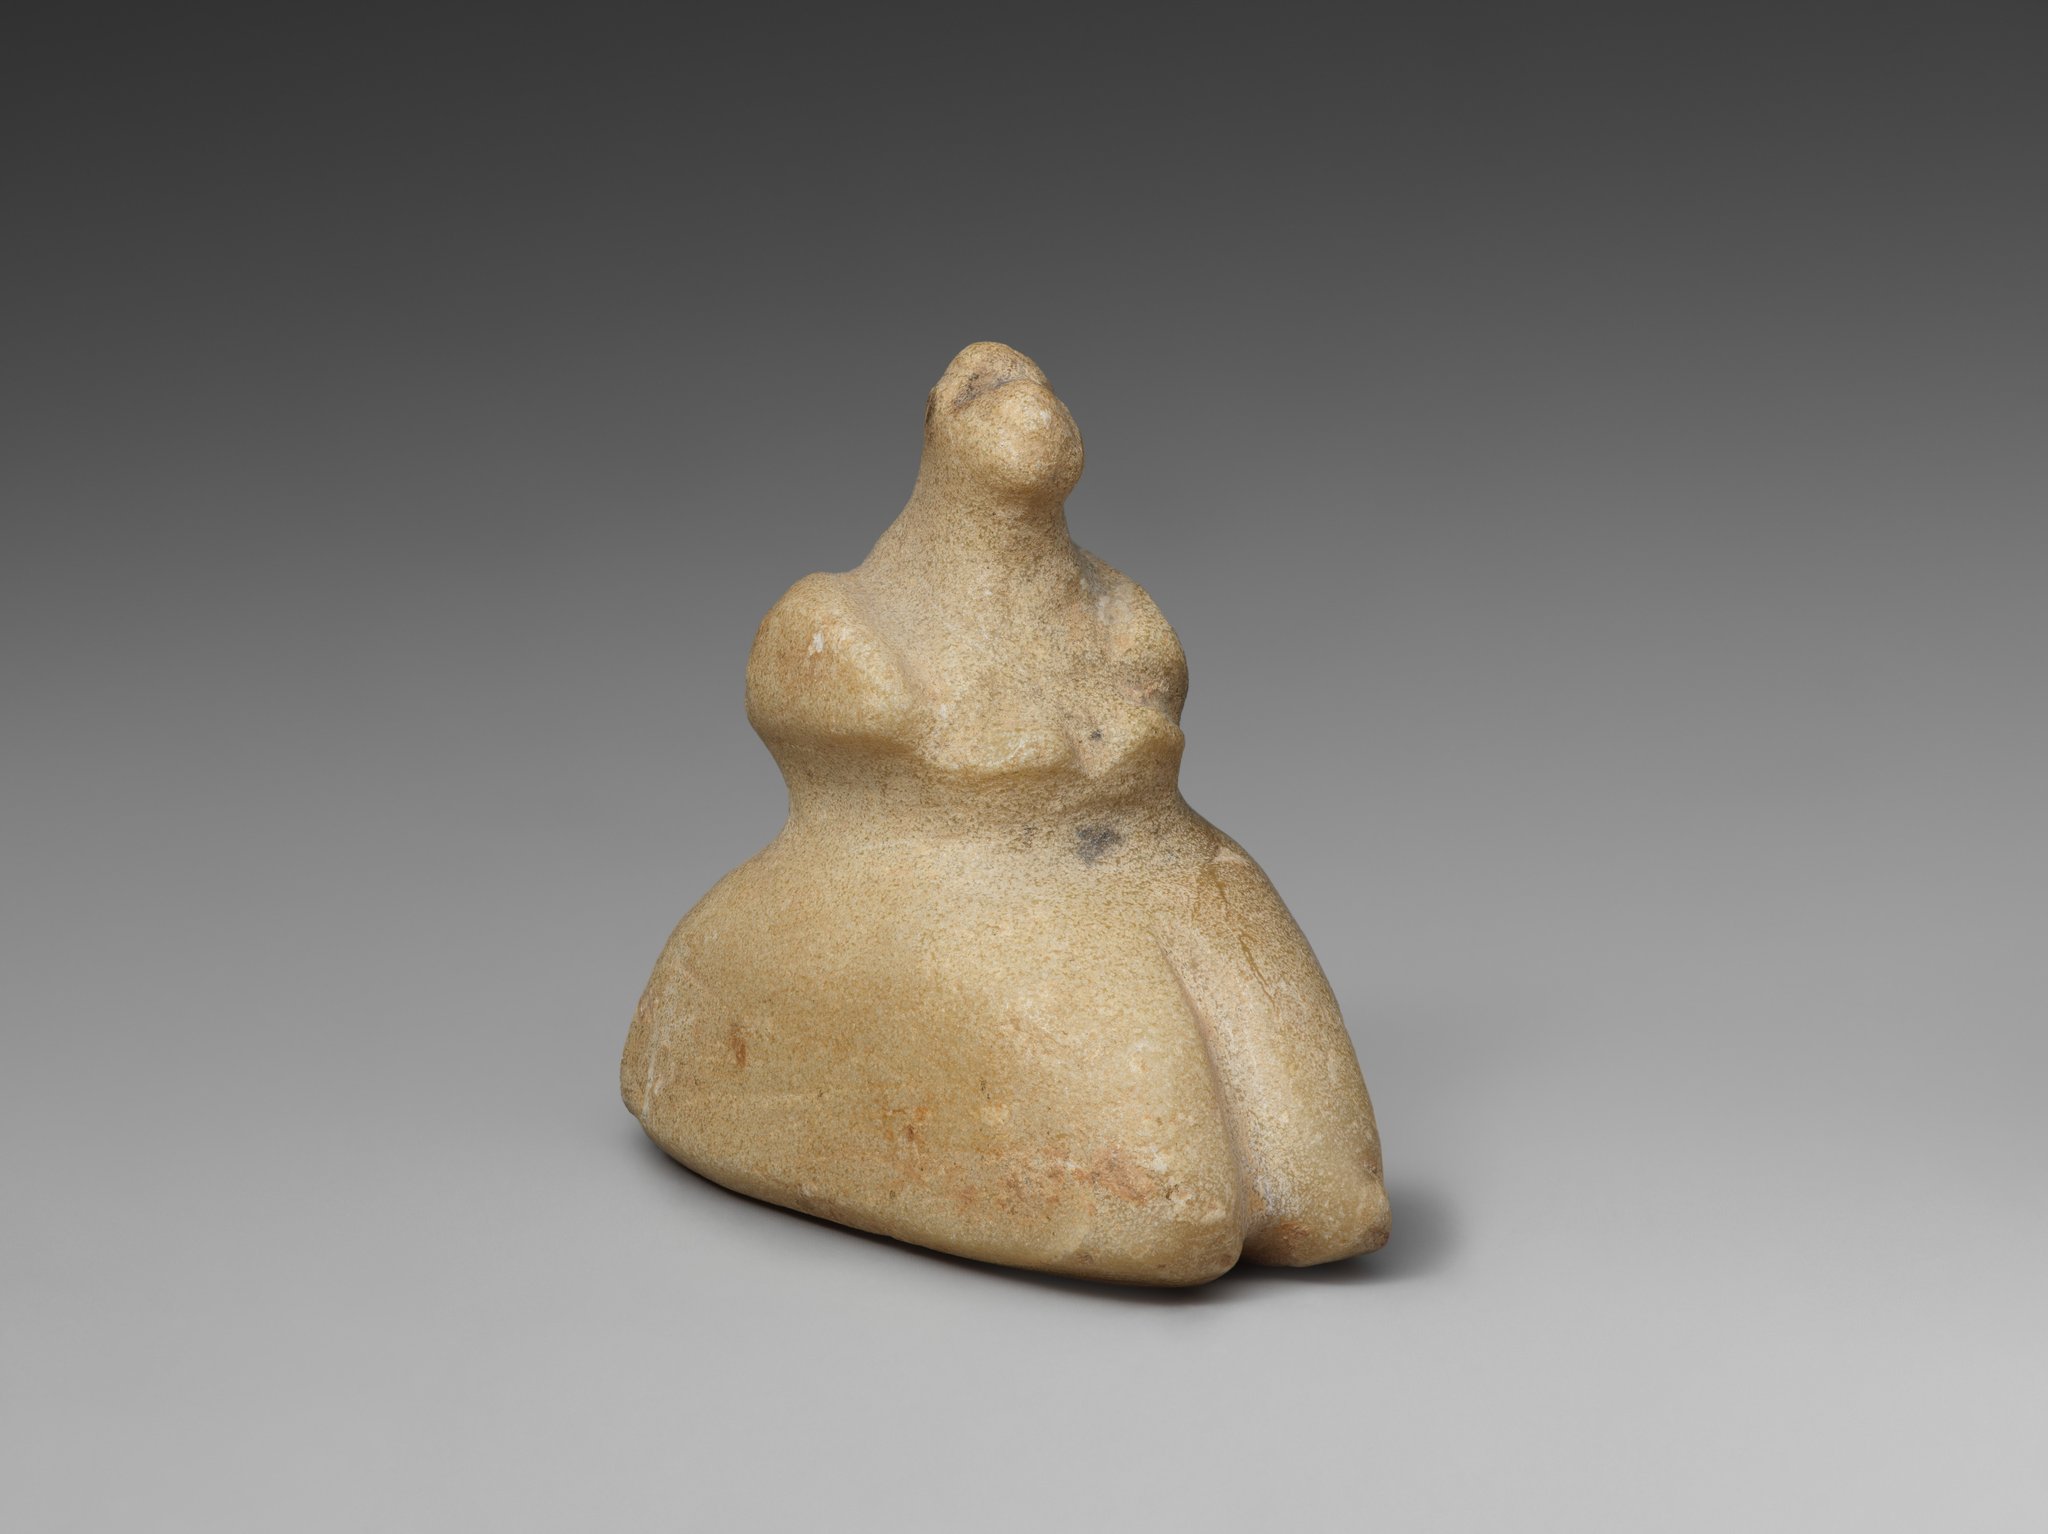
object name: sculpture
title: Seated female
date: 7333-7001 BCE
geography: syria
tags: women